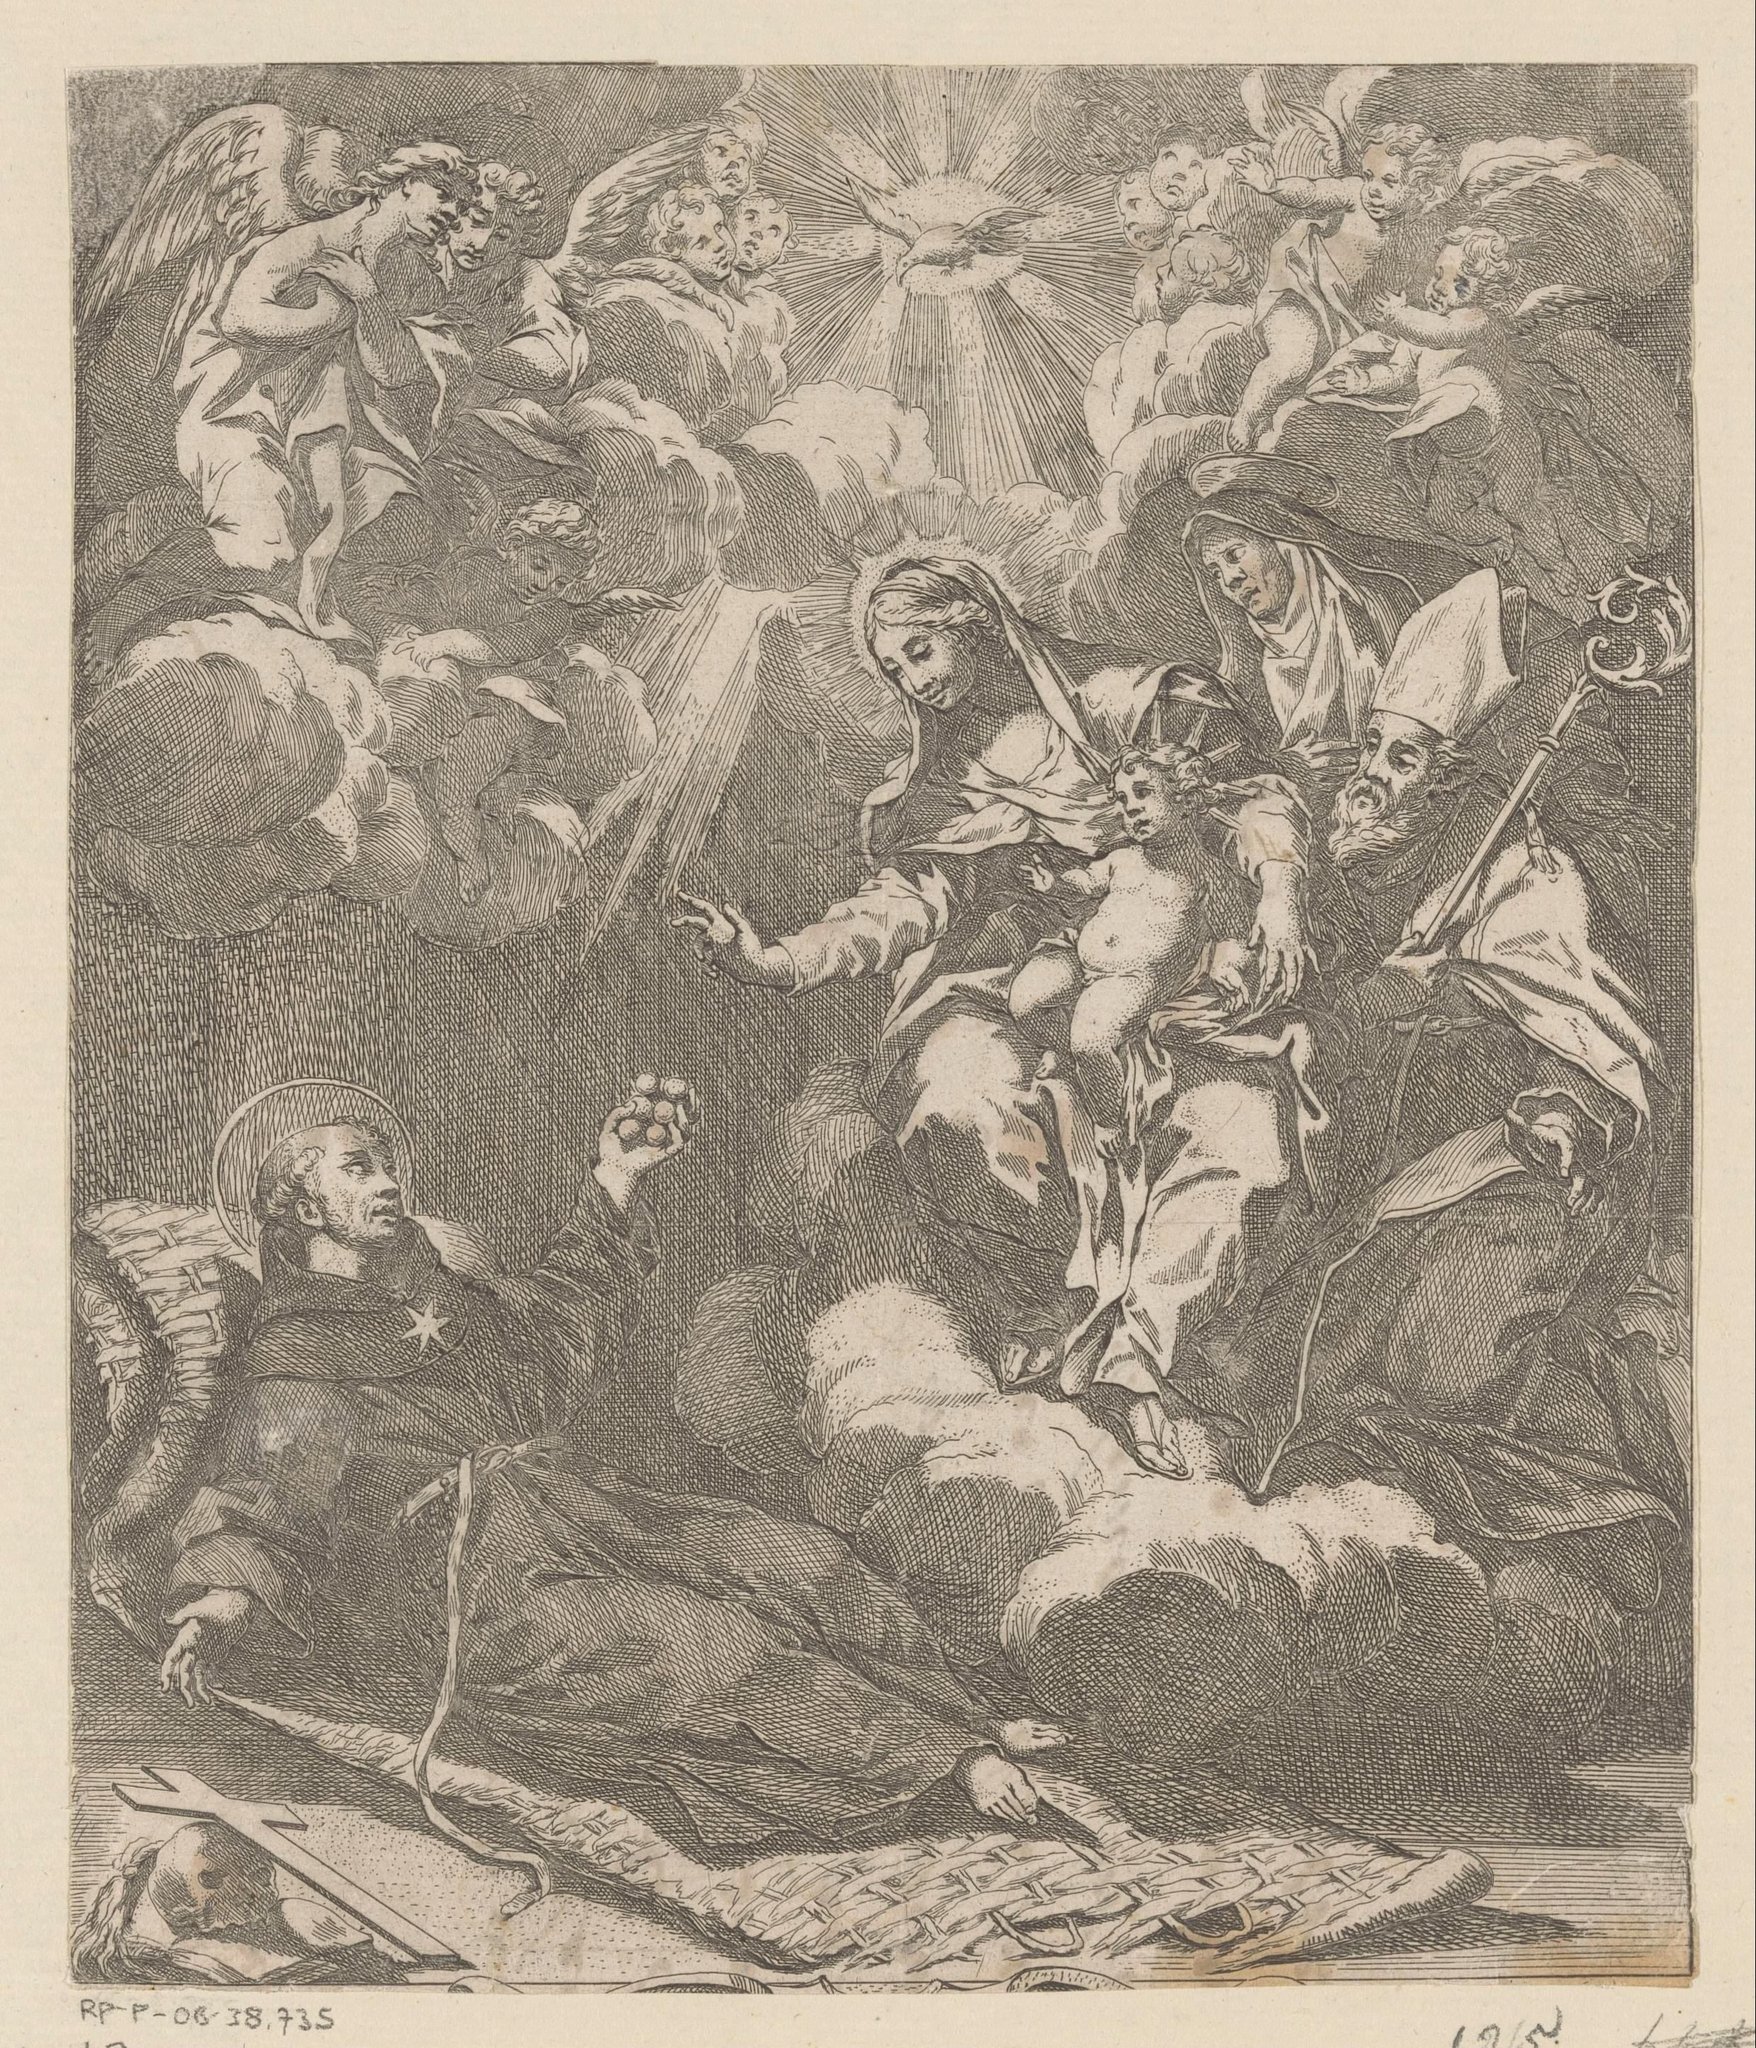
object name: print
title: Maria verschijnt aan een heilige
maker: Anonymous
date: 1600-1699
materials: paper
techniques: etching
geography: italy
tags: madonna: i.e. mary with the christ-child, angels, holy ghost represented as a dove (in flames)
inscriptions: inscription, collector's mark: Lugt 240, collector's mark: Lugt 2228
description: Rechts Maria samen met het Christuskind, een oudere vrouw en een heilige met staf en mijter. Links ligt een heilige op zijn sterfbed. Bovenaan engelen en de Heilige Geest als duif.